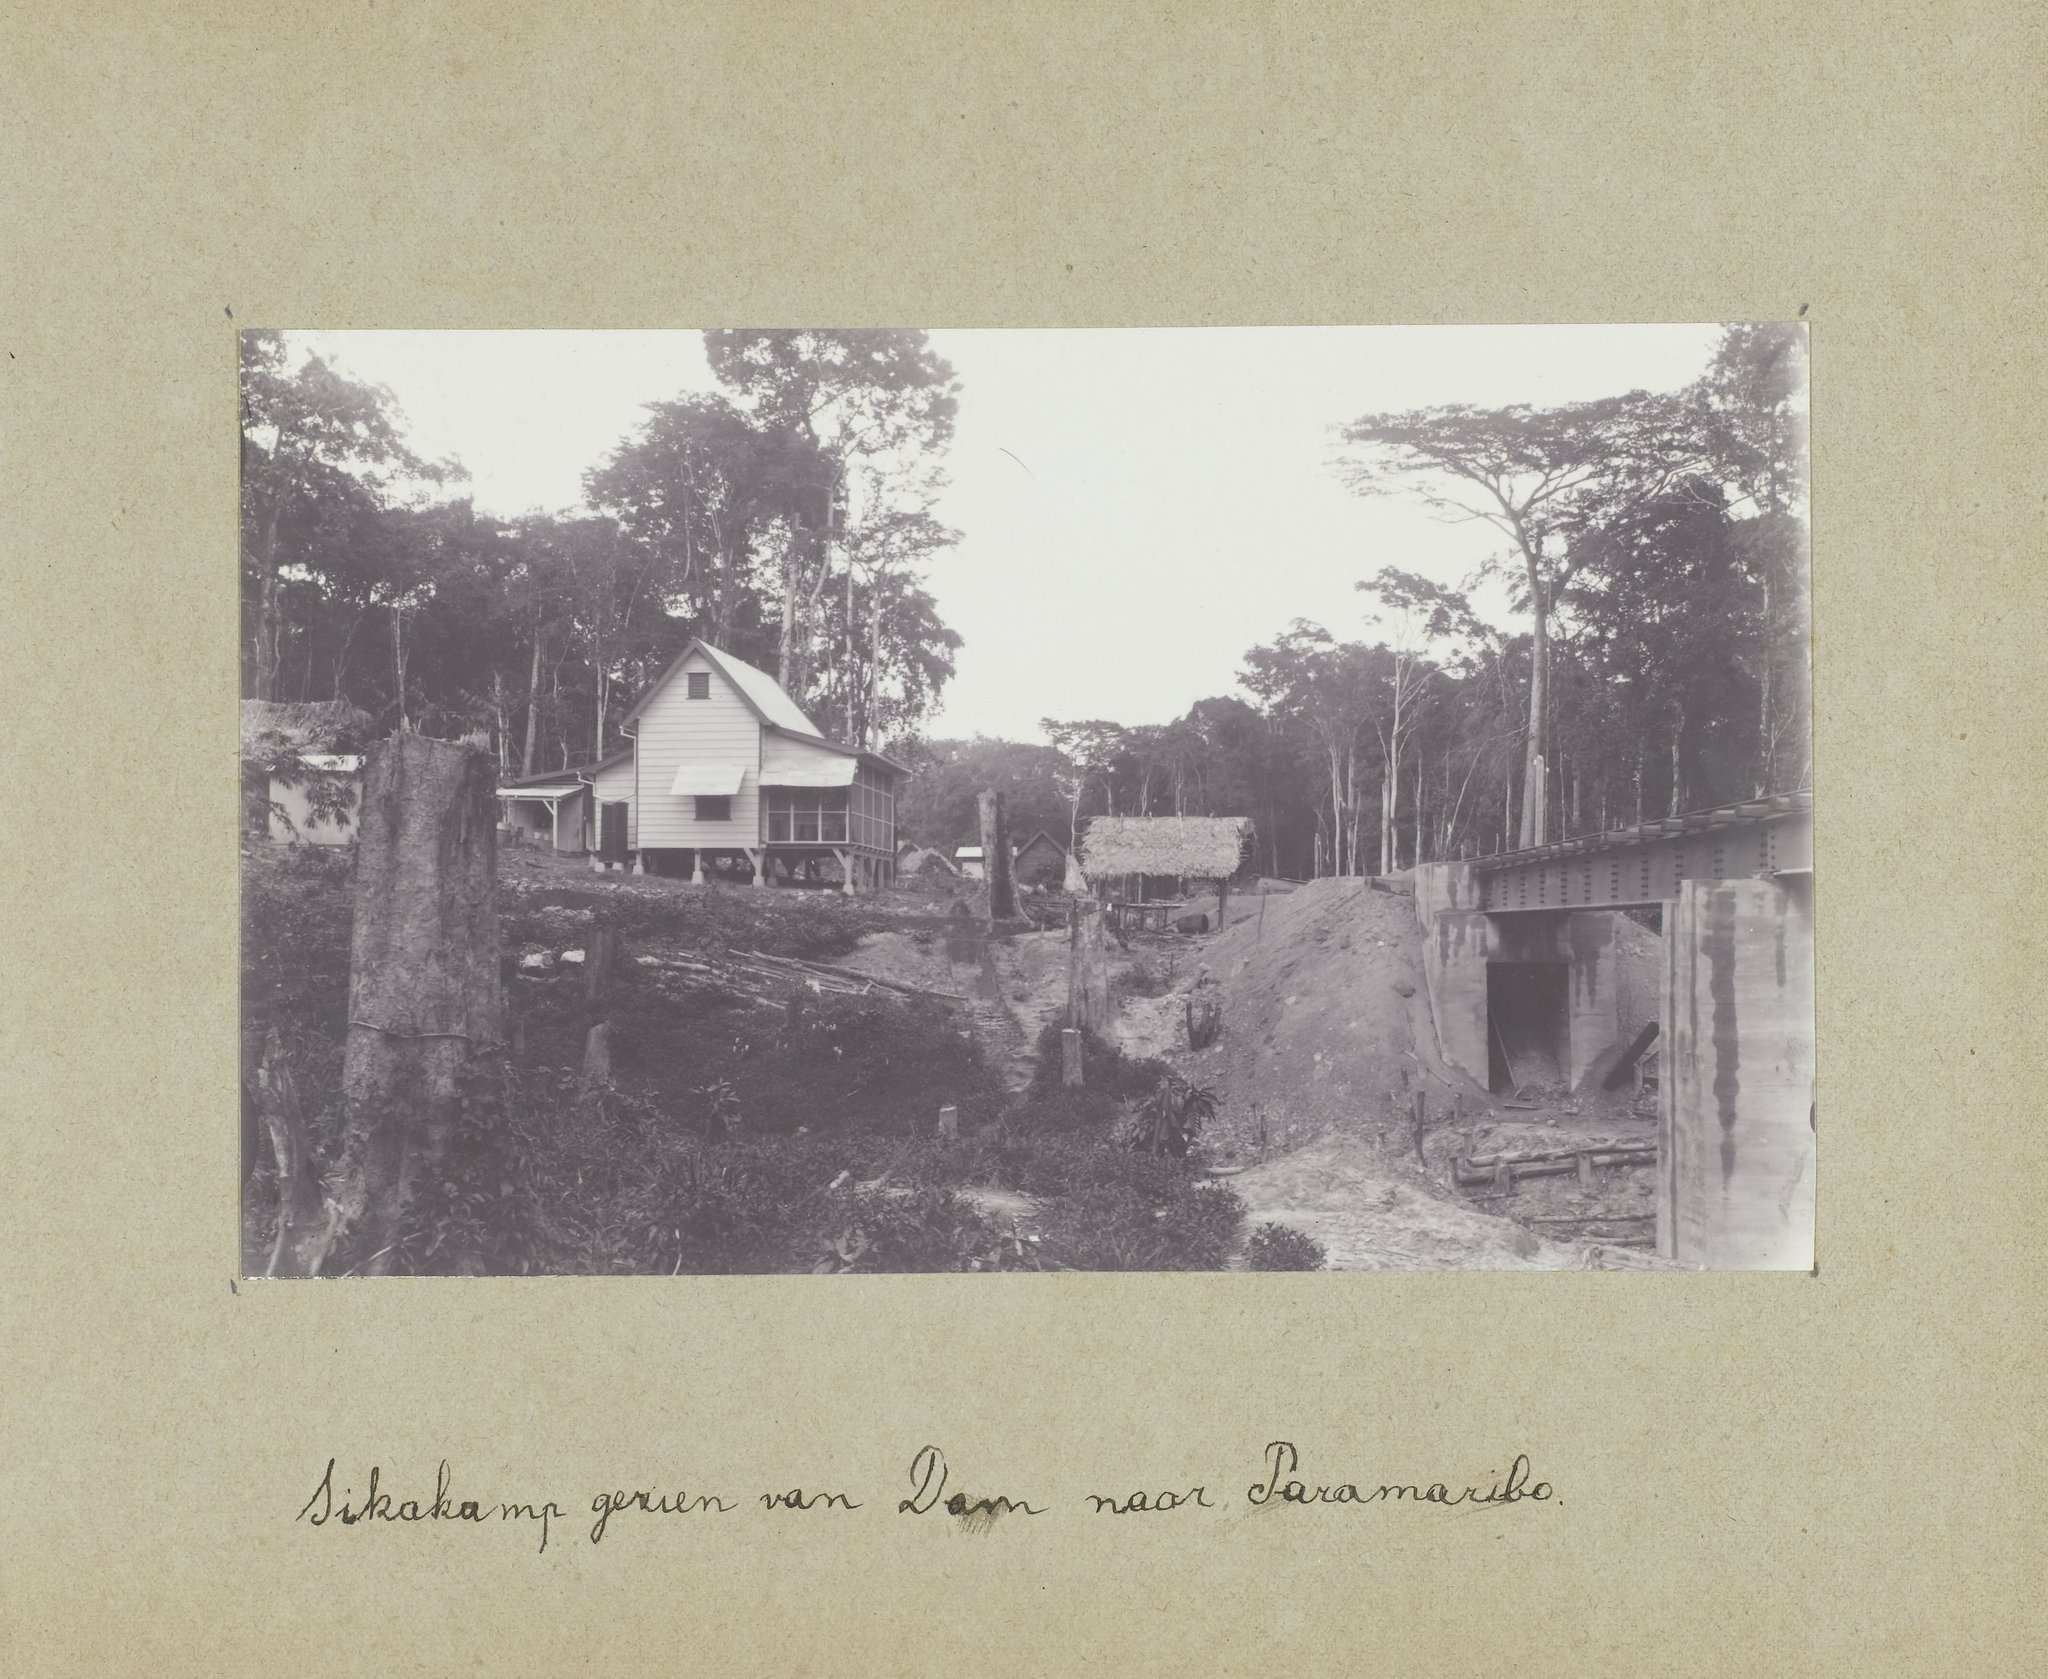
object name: photograph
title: Sikakamp gezien van Dam naar Paramaribo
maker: jacob evert wesenhagen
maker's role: amateurfotograaf, arts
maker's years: 1862-1924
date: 1905-1910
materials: photographic support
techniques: photography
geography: suriname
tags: jacob evert wesenhagen, railway, tramway; rack railway, suriname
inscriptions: inscription: ‘Sikakamp gezien van Dam naar Paramaribo’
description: De nieuwe spoorbaan bij Sikakamp. Foto in het fotoalbum over de aanleg van de Lawaspoorweg in Suriname in de jaren 1903-1912. Onderdeel van een groep objecten afkomstig van de familie Wesenhagen in Suriname.